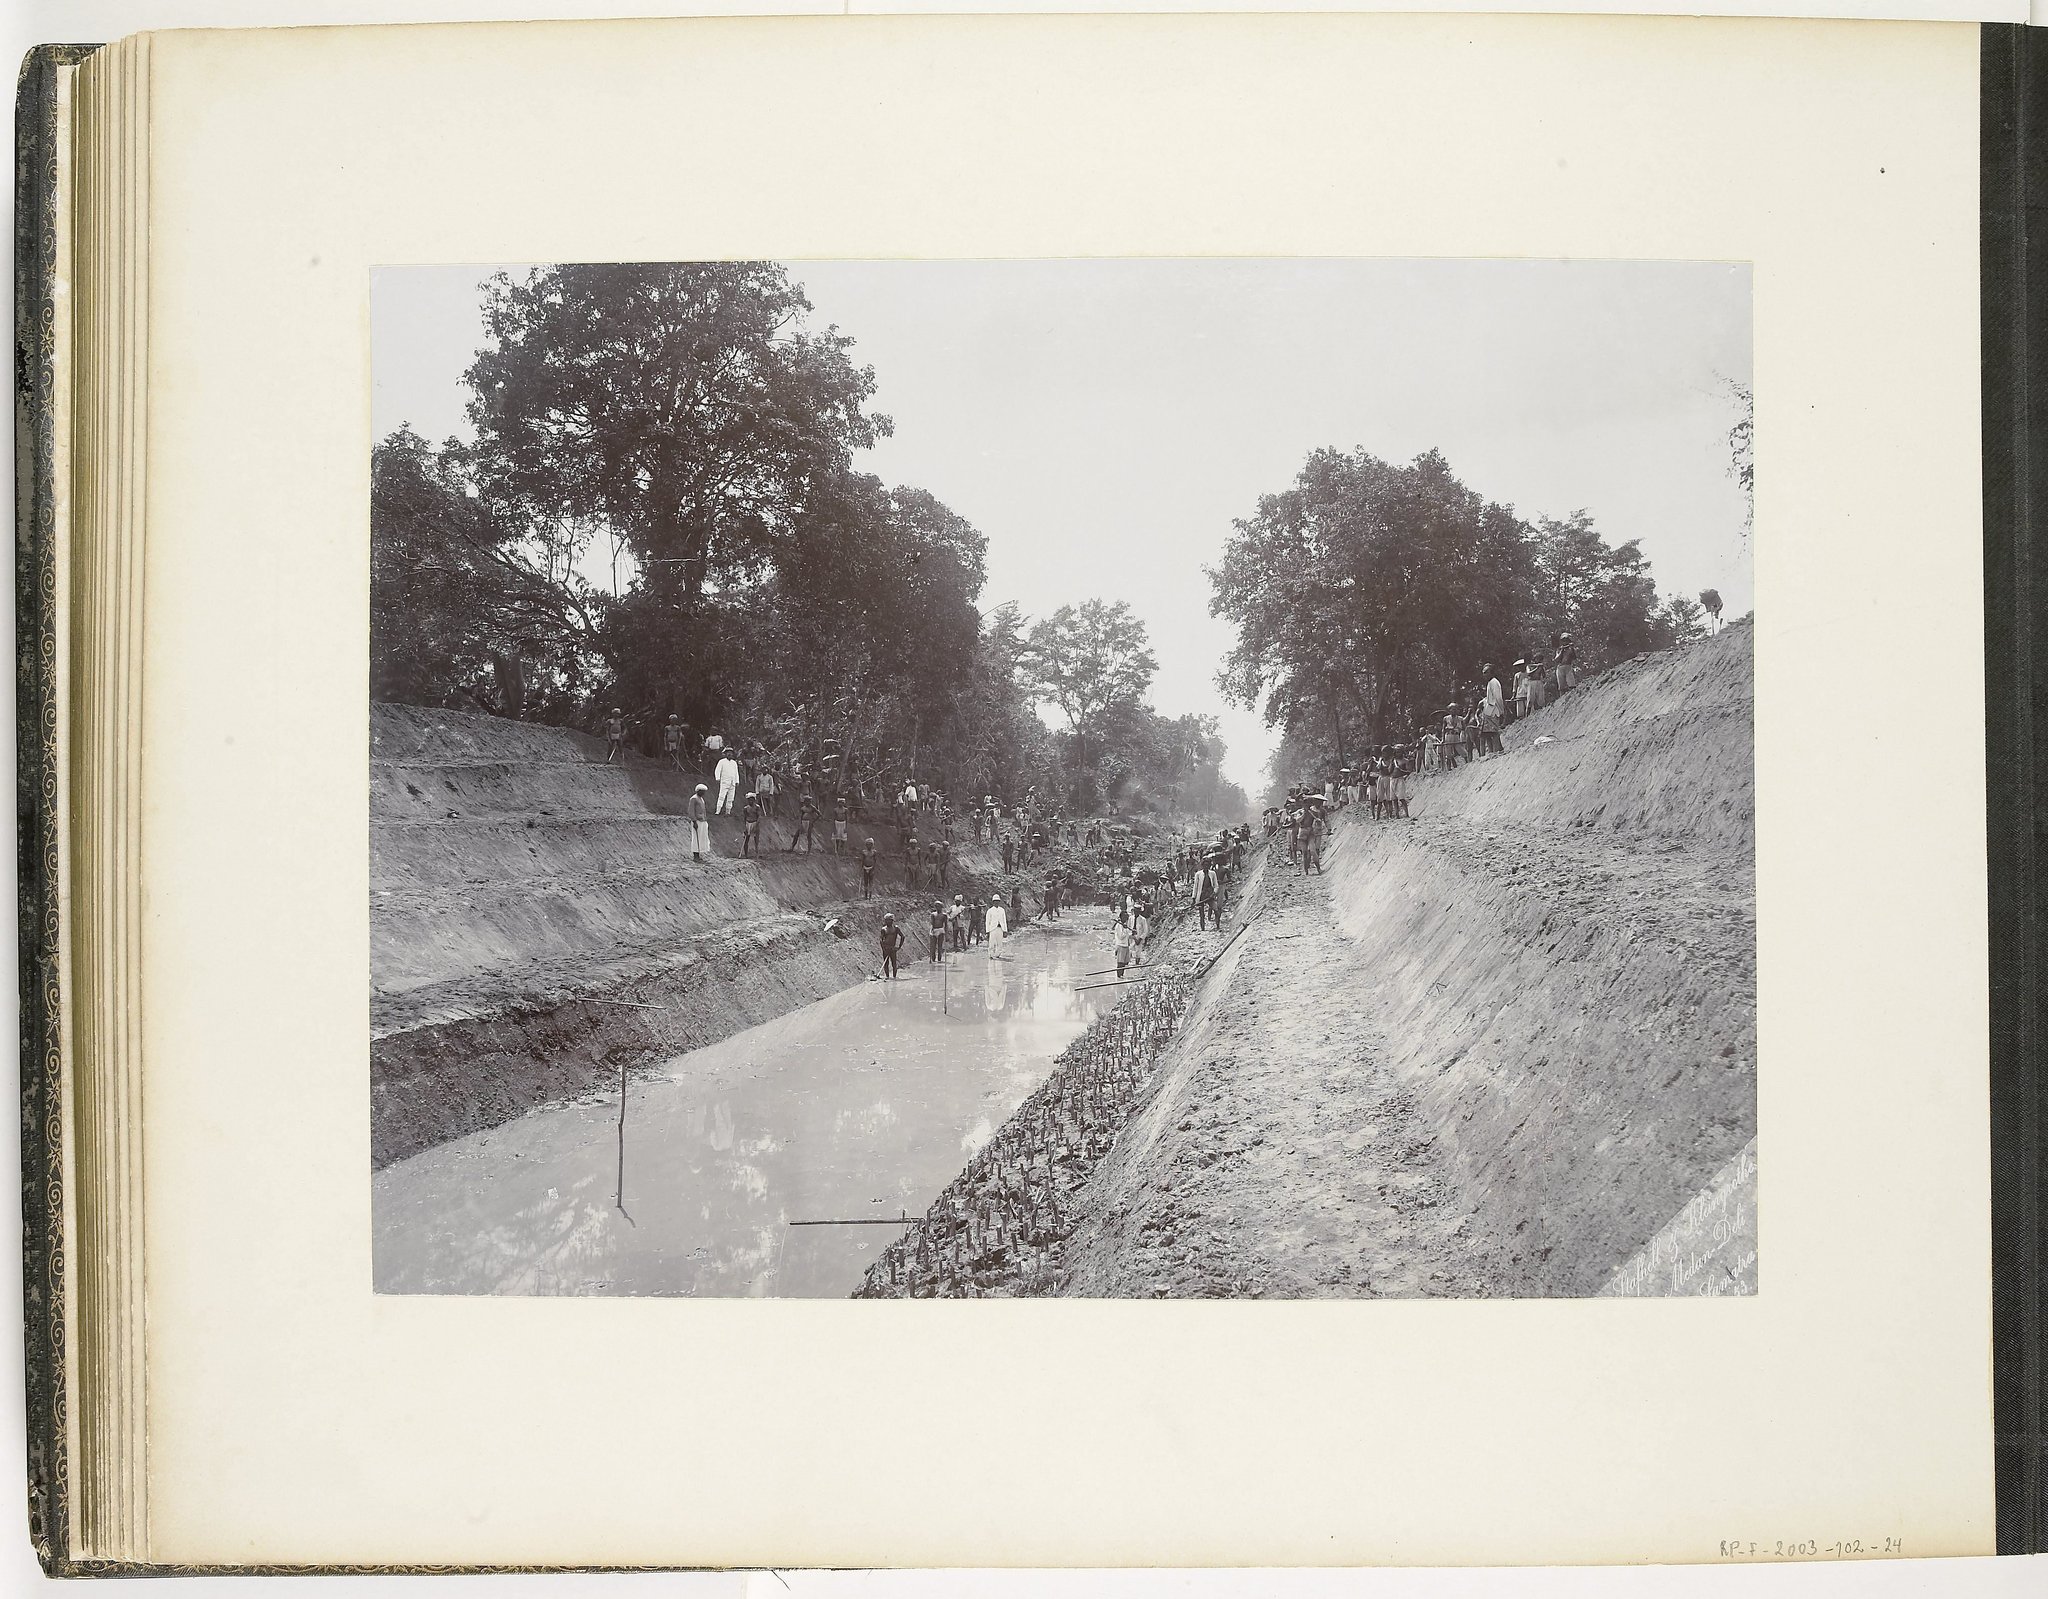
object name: photograph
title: Het graven van het kanaal van Paja-Bakong, Sumatra (Canal Paya Bakon)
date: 1890-1900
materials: photographic support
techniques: collodion silver print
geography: medan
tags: deli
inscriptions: number: ‘Sumatra 53.’, signature: ‘Stafhell & Kleingrothe Medan- Deli’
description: Een grote groep arbeiders bezig met het graven van een kanaal op de landbouwonderneming Paja-Bakong in Deli in de Oostkust van Sumatra. Onderdeel van het Sumatra fotoalbum van Paul en Lucie Sandel uit 1900.